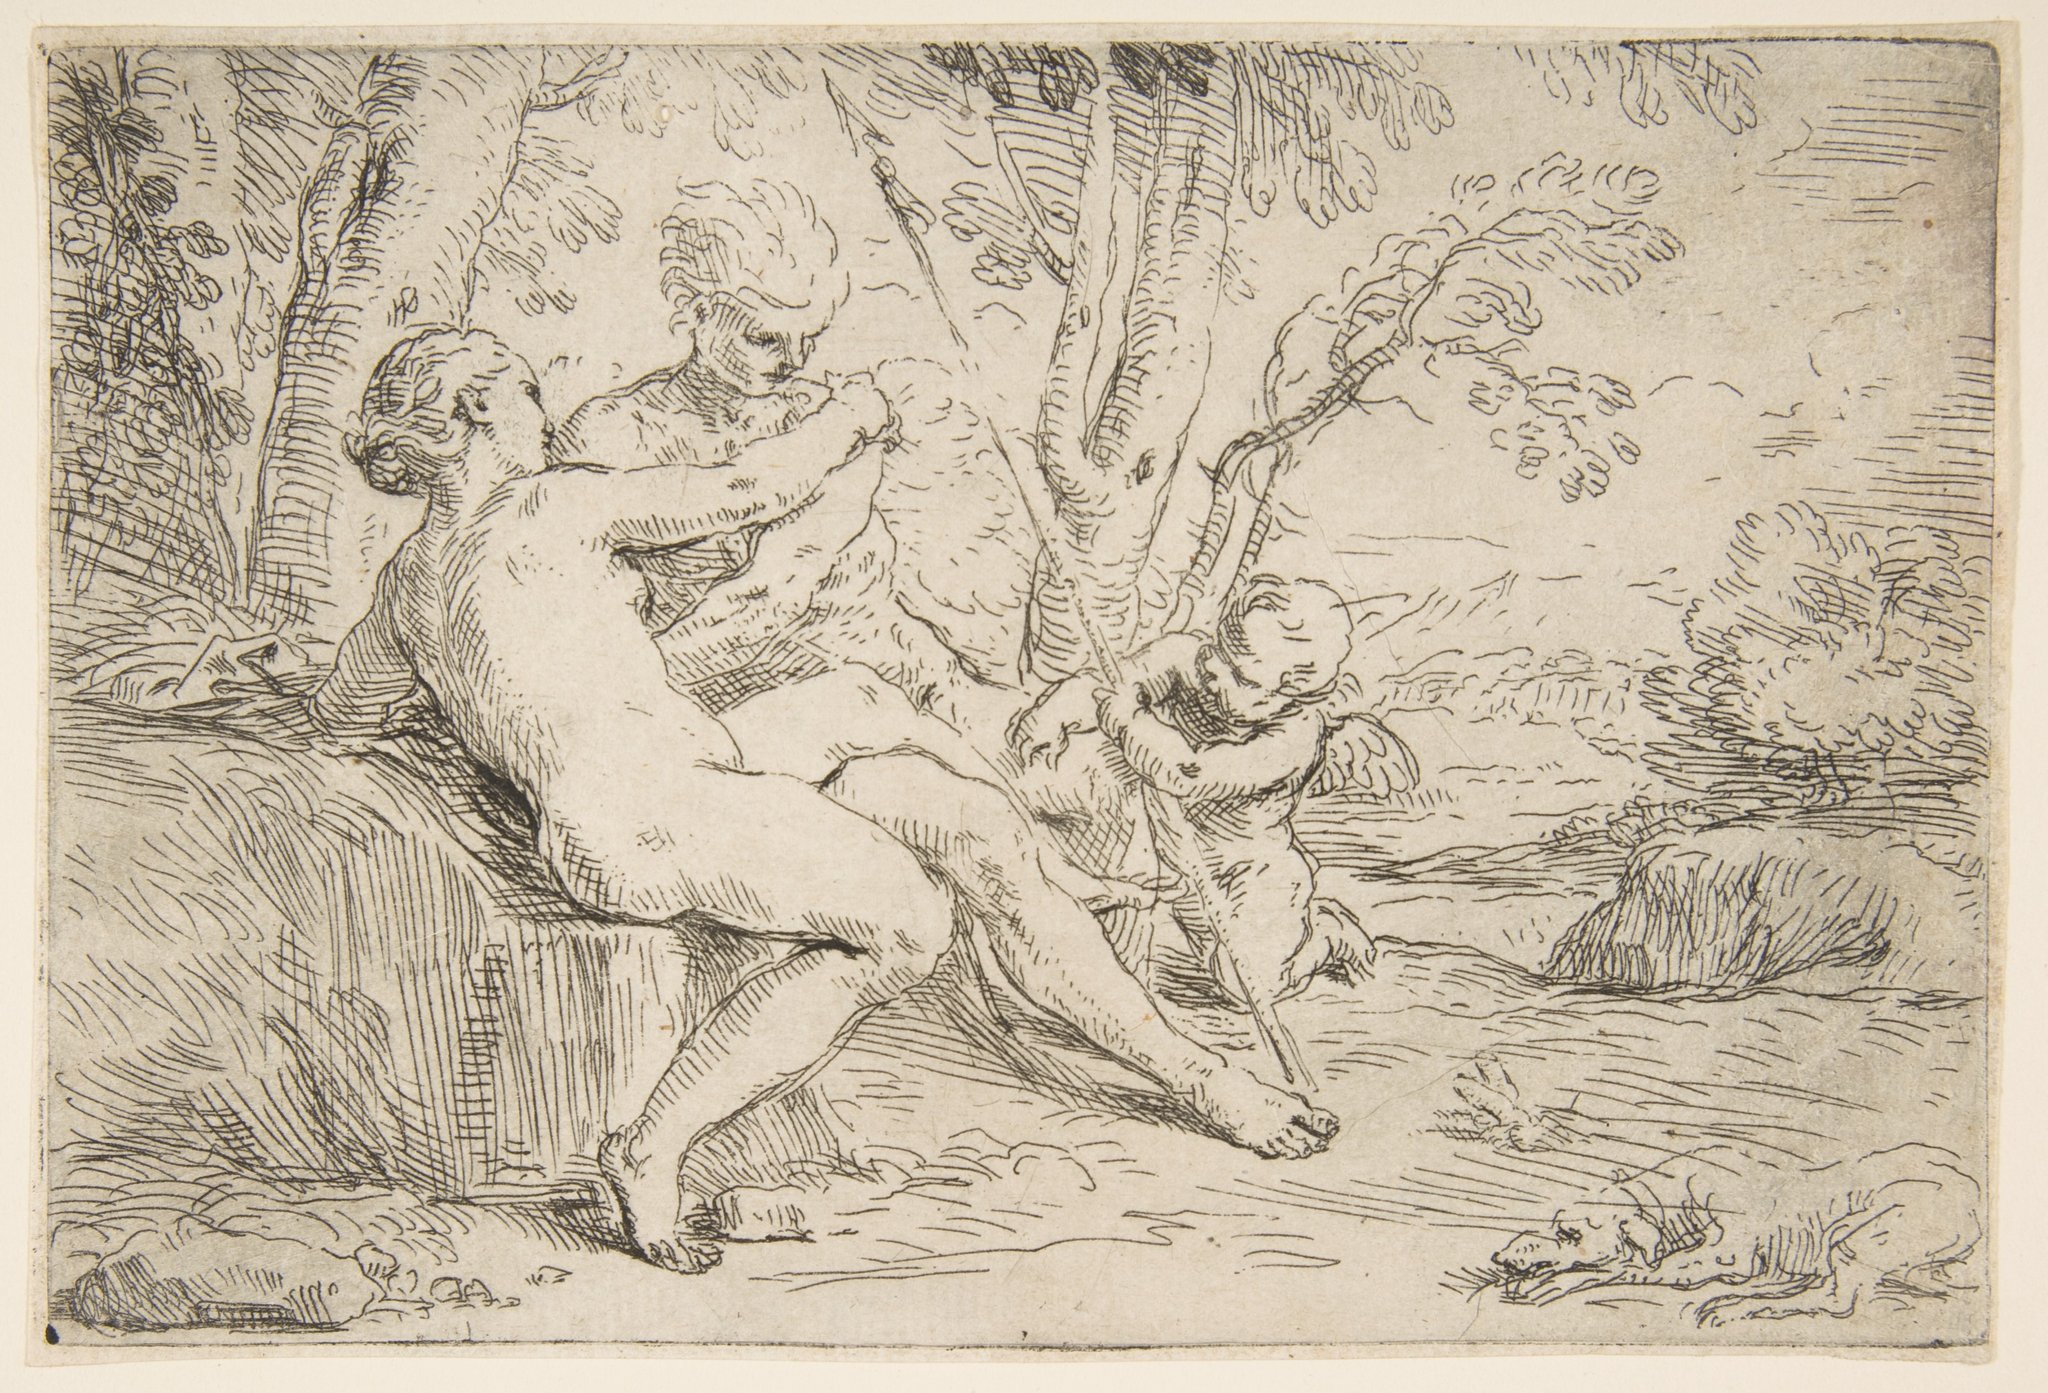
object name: print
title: Venus and Adonis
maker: simone cantarini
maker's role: artist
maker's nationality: italian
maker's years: 1612-1648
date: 1637-1639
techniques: etching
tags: spears,adonis,venus